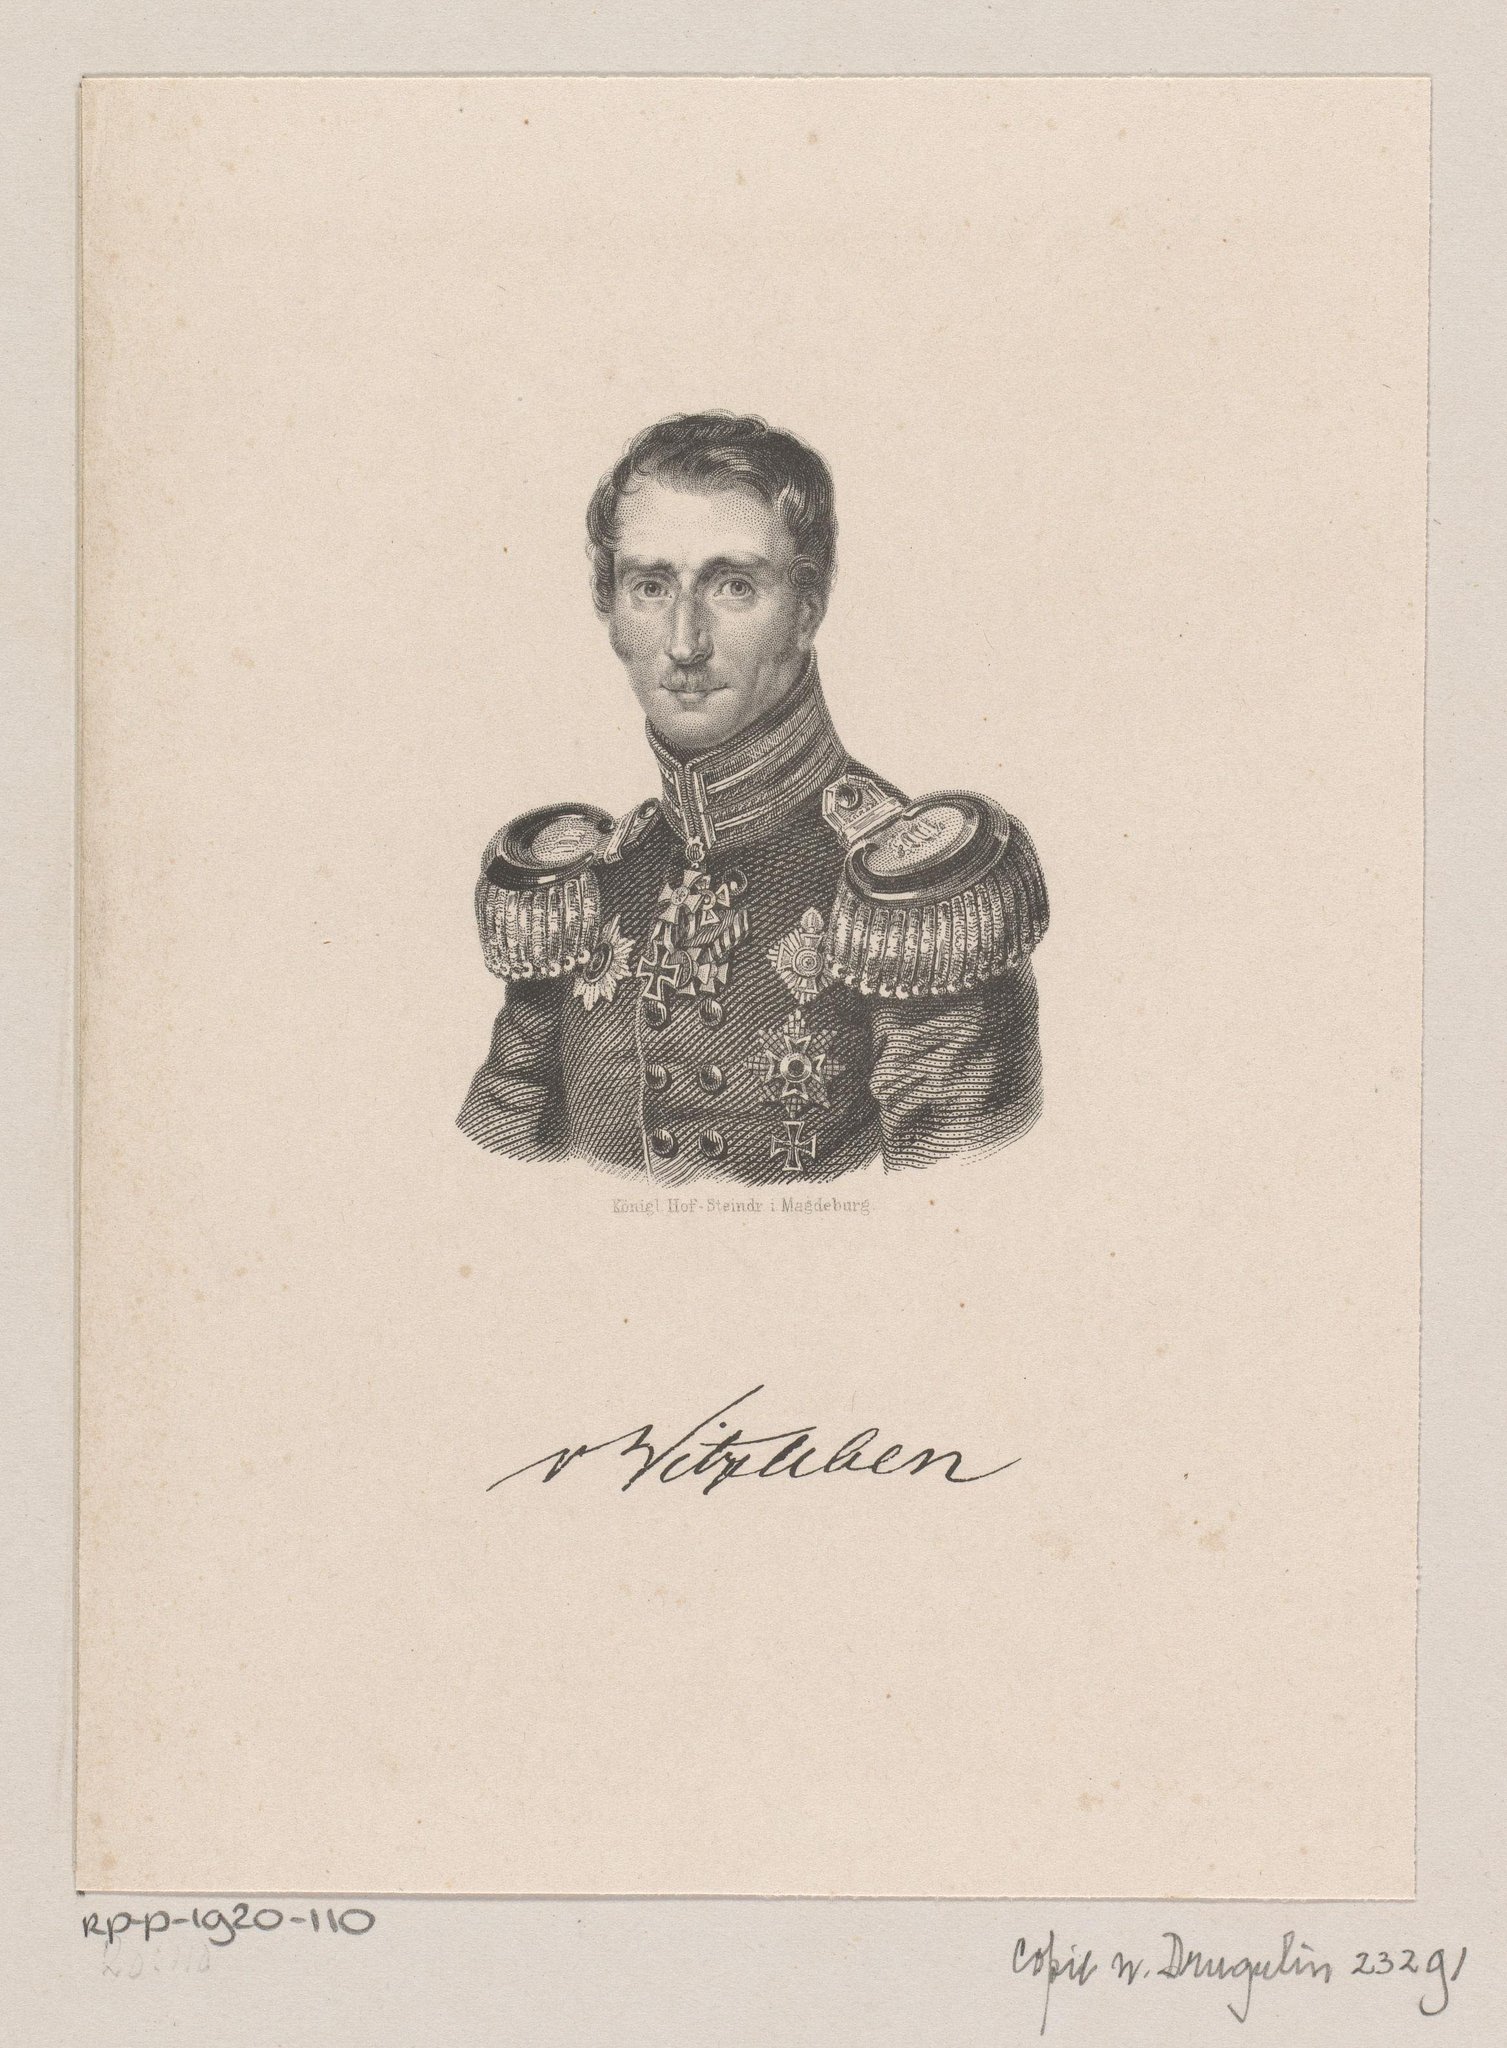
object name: print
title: Portret van Job von Witzleben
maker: Anonymous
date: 1850-1899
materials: paper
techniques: lithograph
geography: germany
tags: berlin, politician, moustache, commander-in-chief, general, marshal, historical persons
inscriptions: collector's mark: Lugt 2228